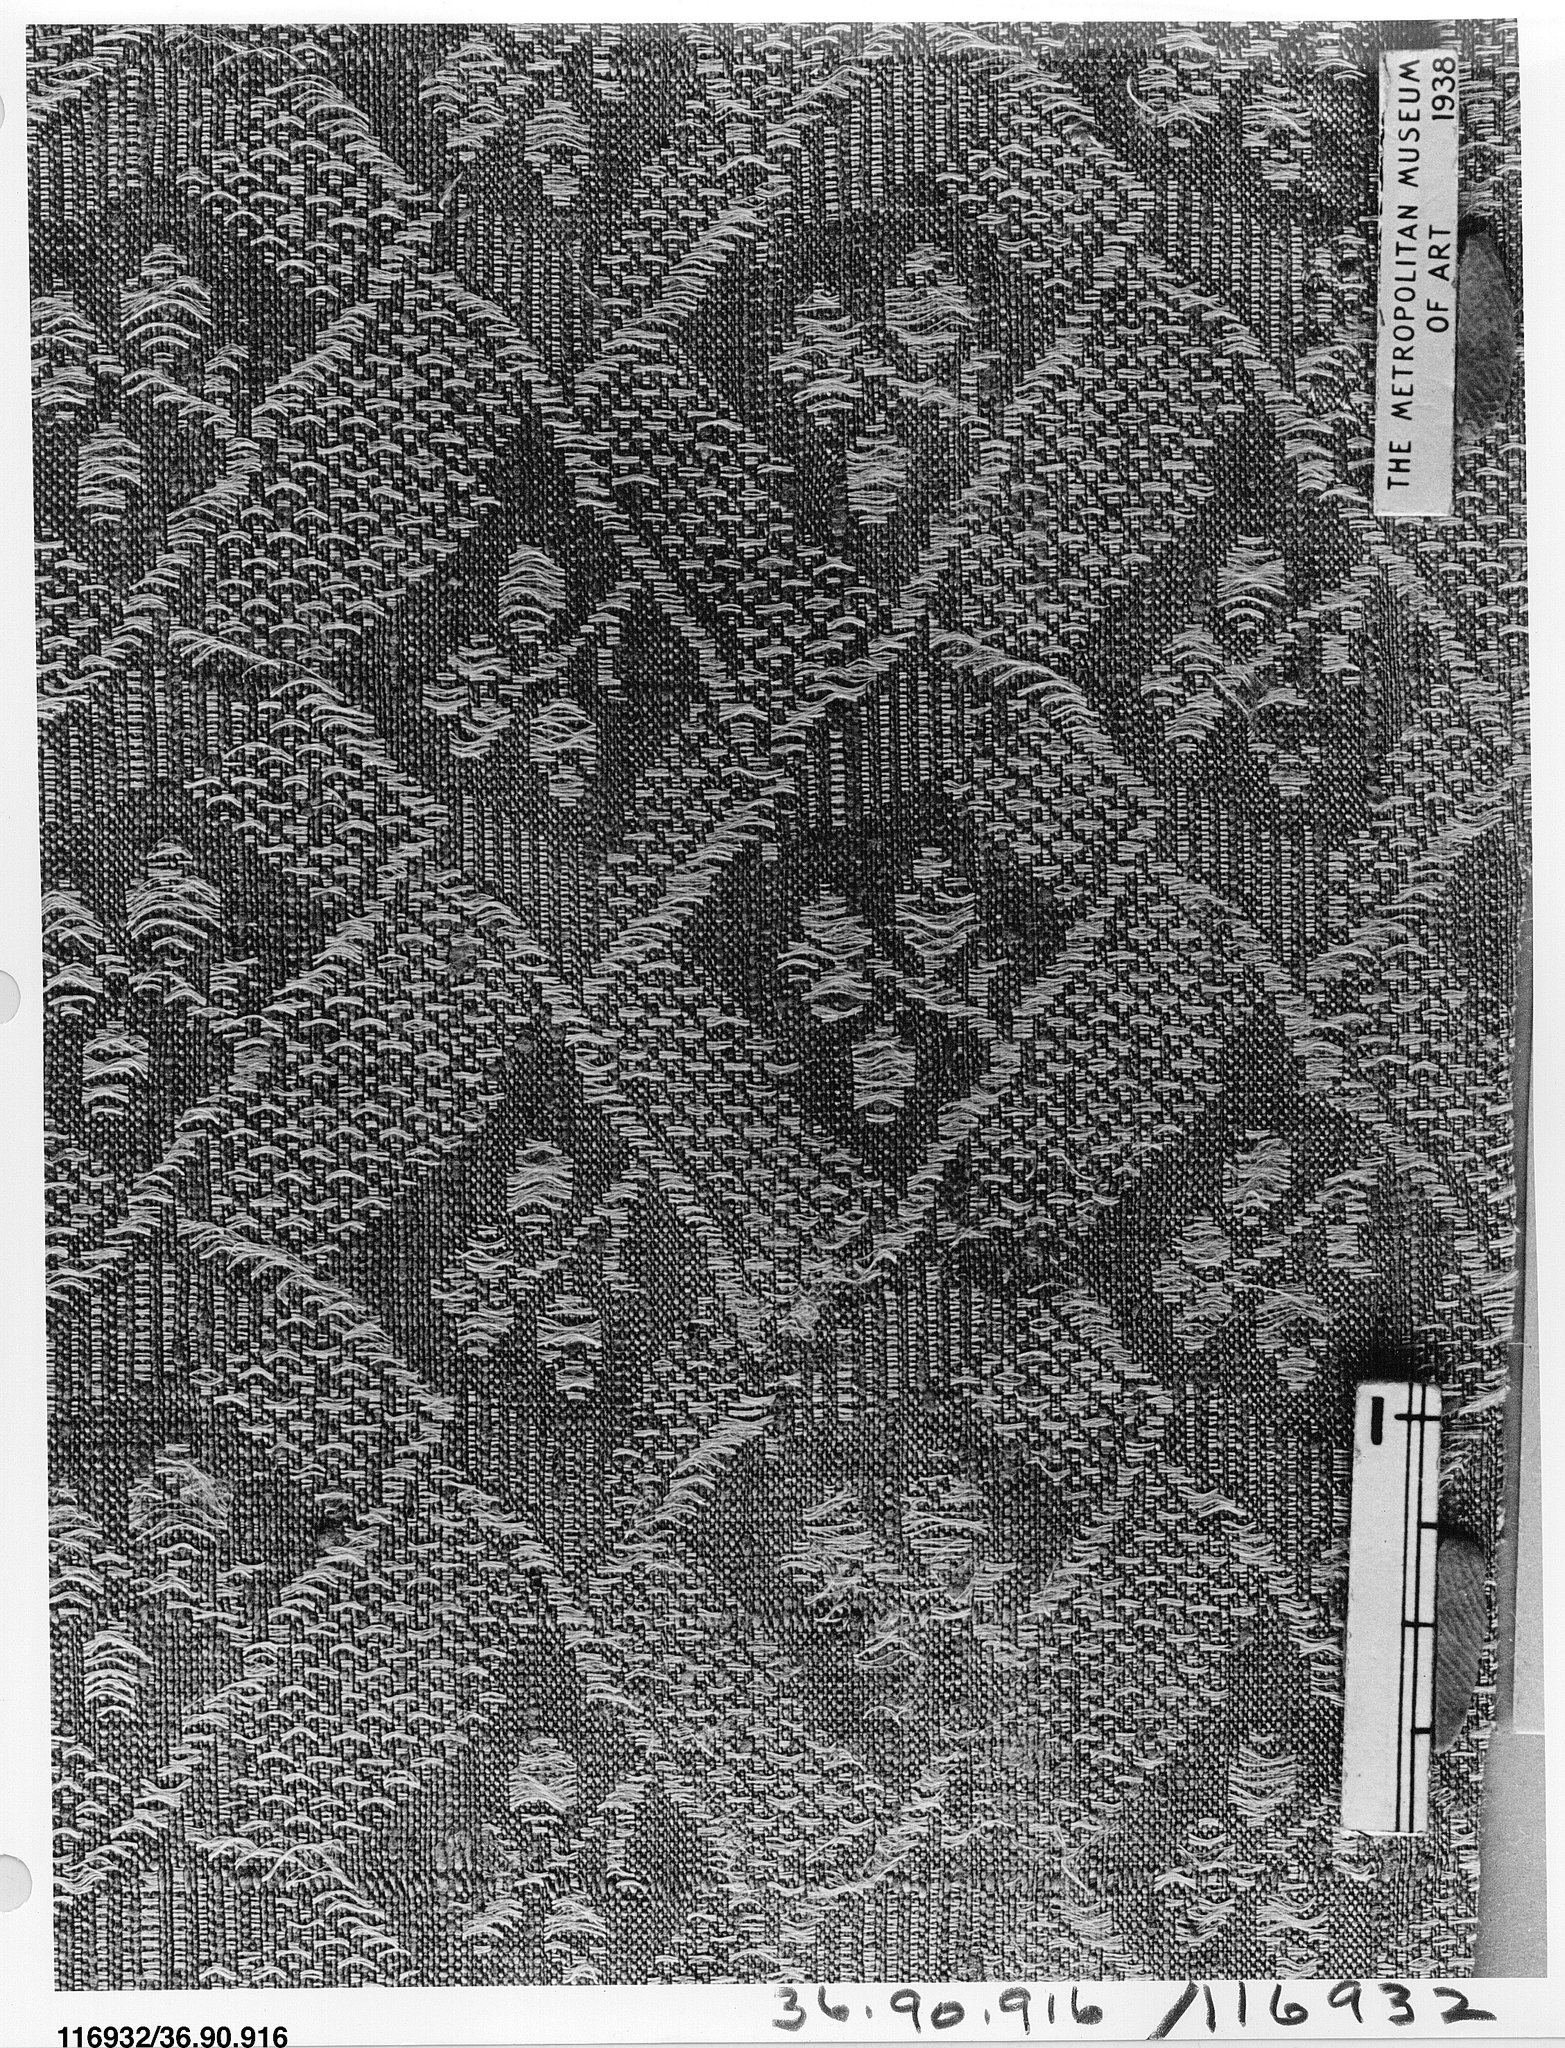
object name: piece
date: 1701-1800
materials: silk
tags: flowers,leaves